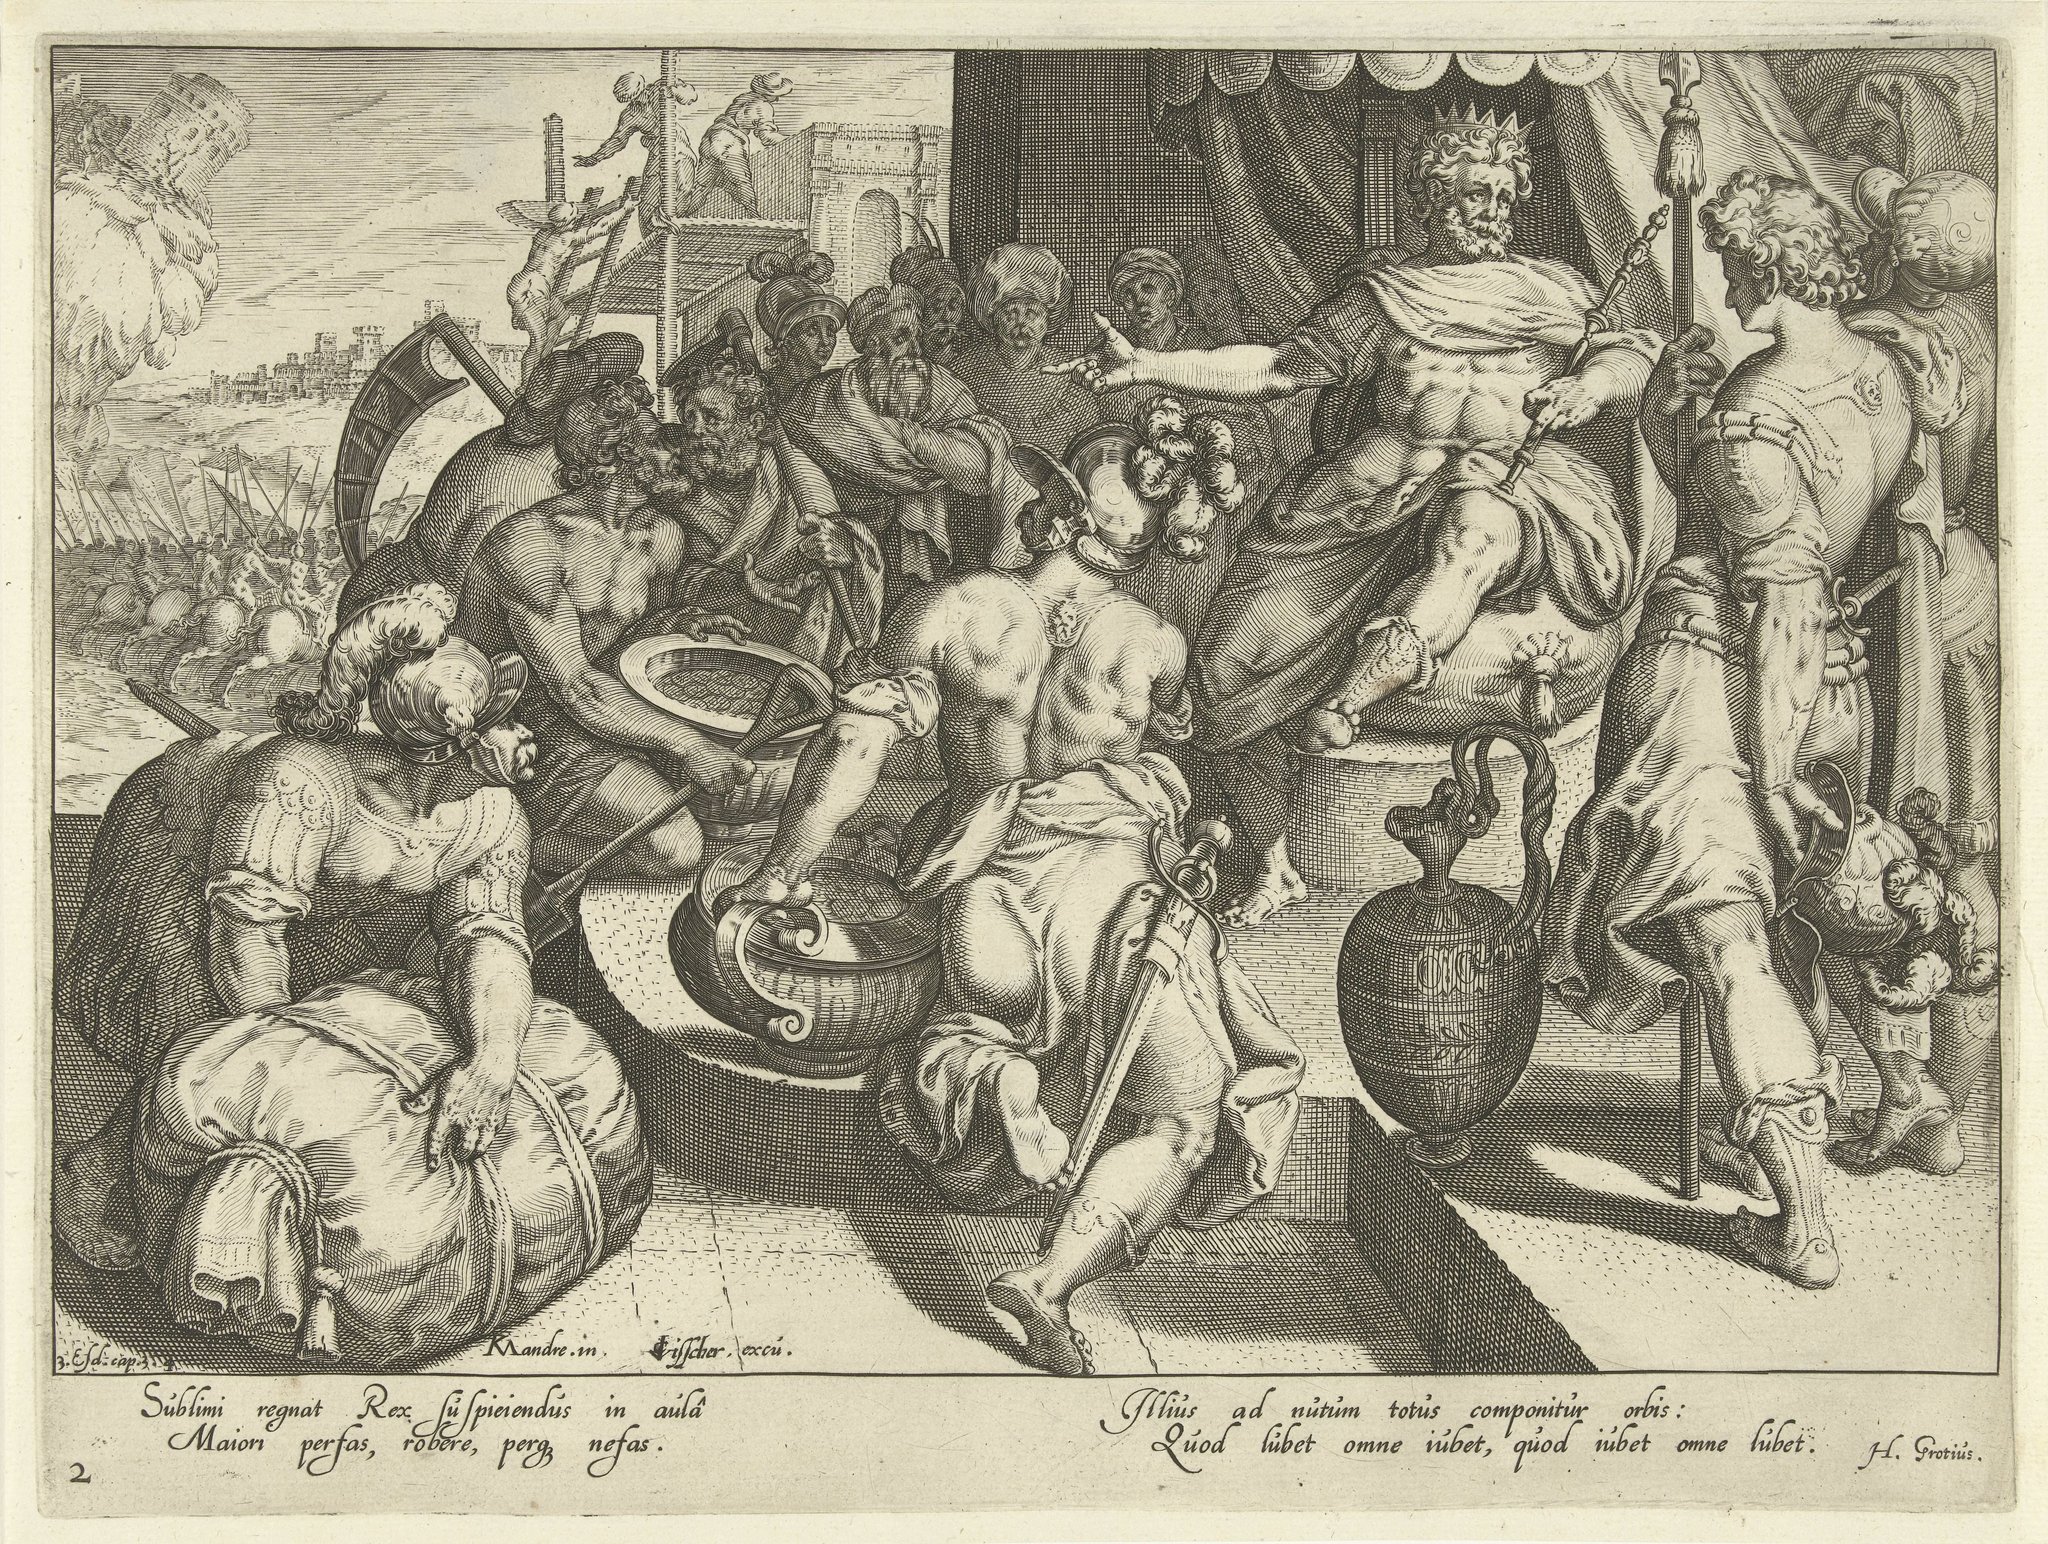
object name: print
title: De koning als sterkste in de wereld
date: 1595-1596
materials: paper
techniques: engraving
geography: amsterdam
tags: king, the first guardsman says (writes) that wine is the strongest of all things ~ contest of the three guardsmen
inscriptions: collector's mark: Lugt 2228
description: Verschillende personen brengen hun schatten naar de koning die op zijn troon zit. Twee mannen dragen grote vazen met munten, een andere man brengt een baal dure stoffen. Op de achtergrond wordt een nieuw paleis gebouwd en trekt een leger ten strijde. Voorstelling uit het boek 3 Ezra 3-4.